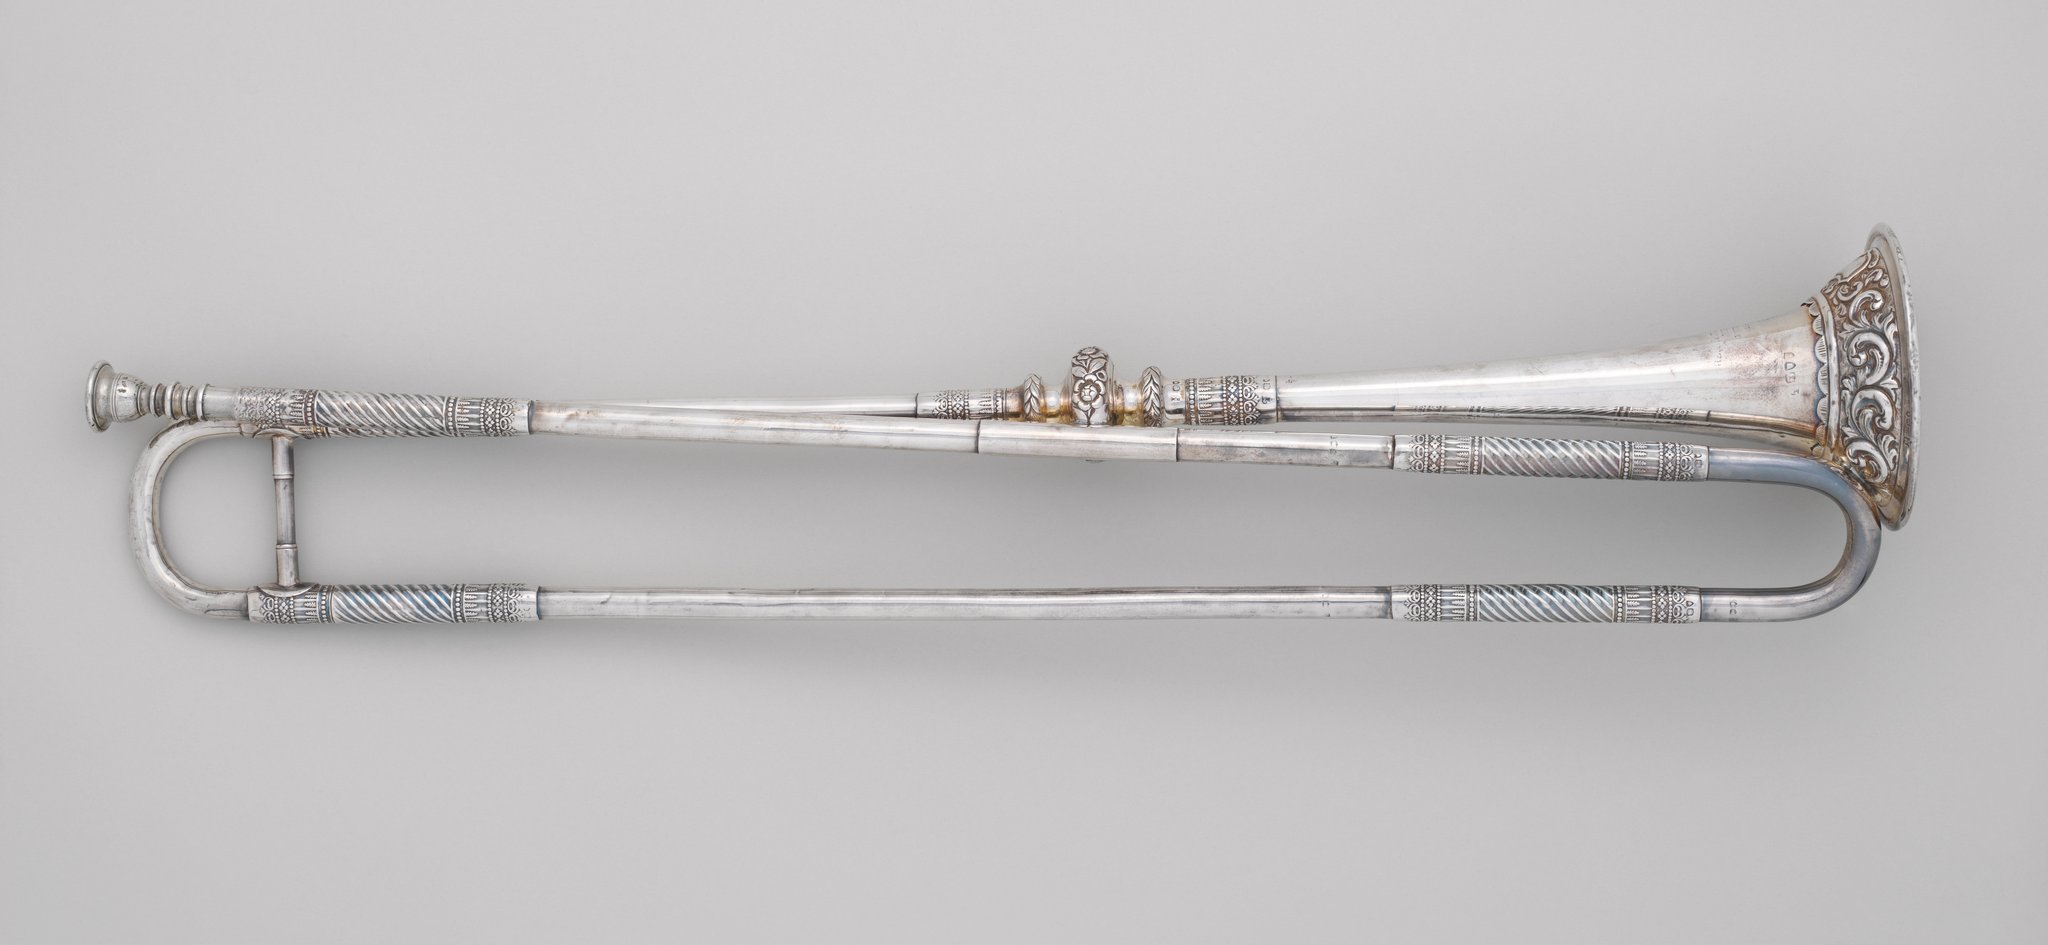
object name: trumpet in e flat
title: Trumpet in E-flat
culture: british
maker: henry keat & sons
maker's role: maker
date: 1894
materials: silver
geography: united kingdom